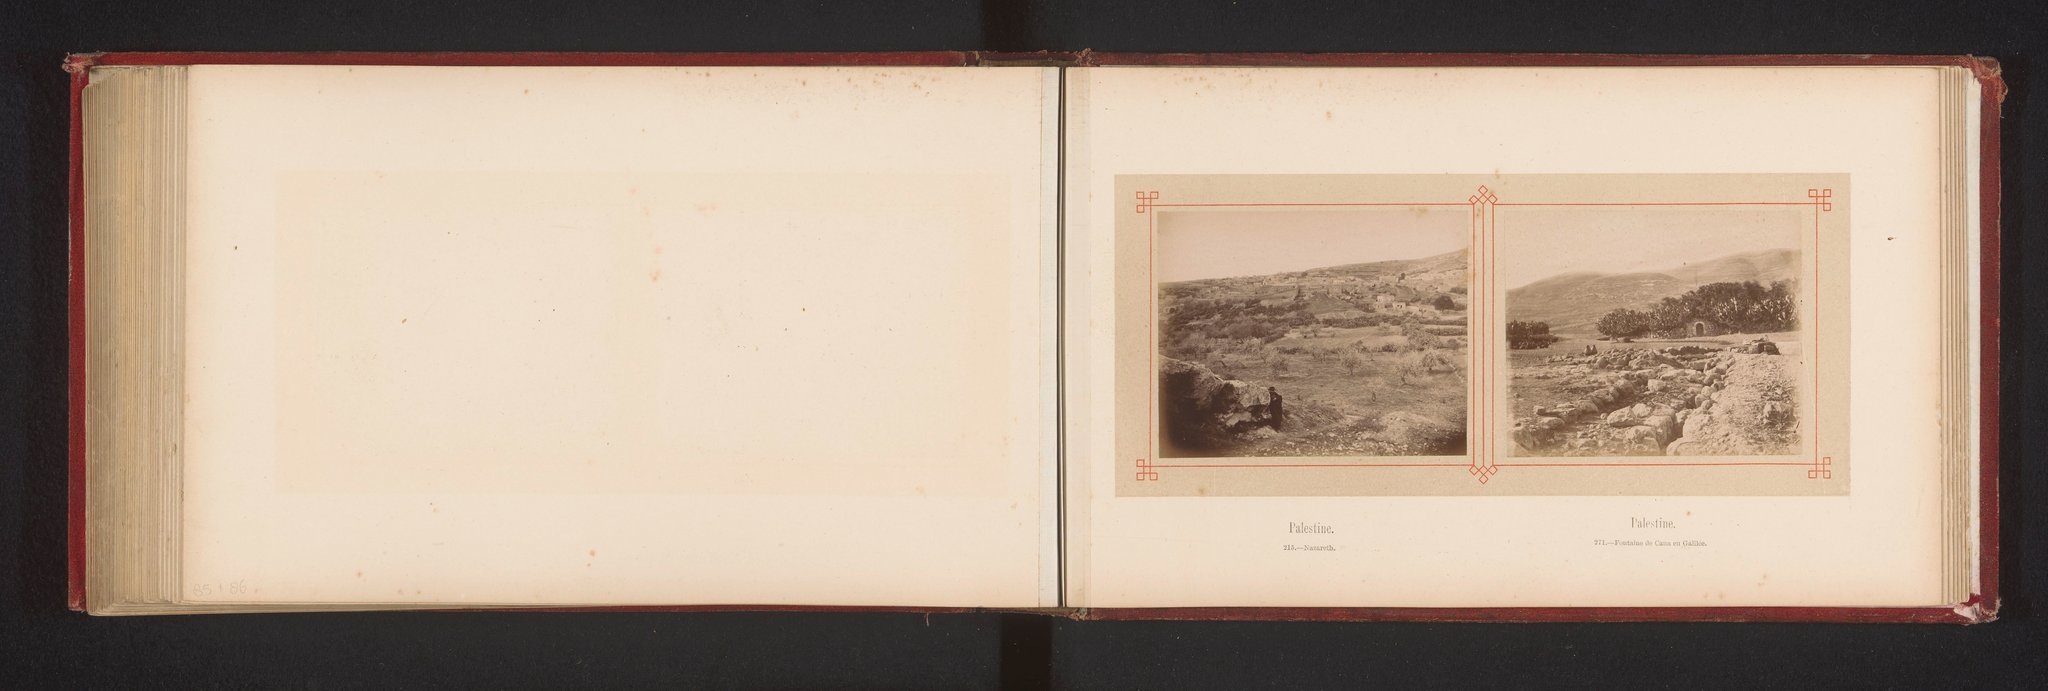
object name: page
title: Palestine - 215.- Nazareth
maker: félix bonfils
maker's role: fotograaf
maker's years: 1831-1885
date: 1873-1878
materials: photographic support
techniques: albumen print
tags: city-view in general; 'veduta'